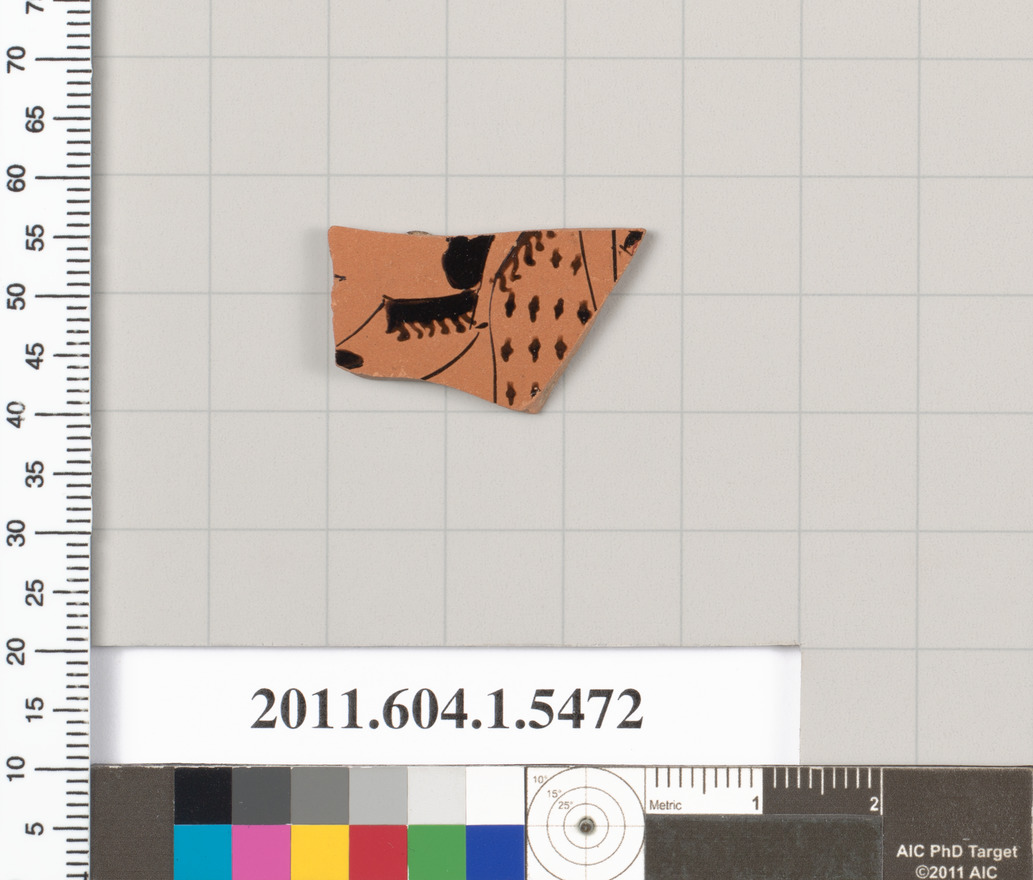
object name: kylix fragment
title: Terracotta fragment of a kylix (drinking cup)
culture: greek, attic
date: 500-480 BCE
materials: terracotta